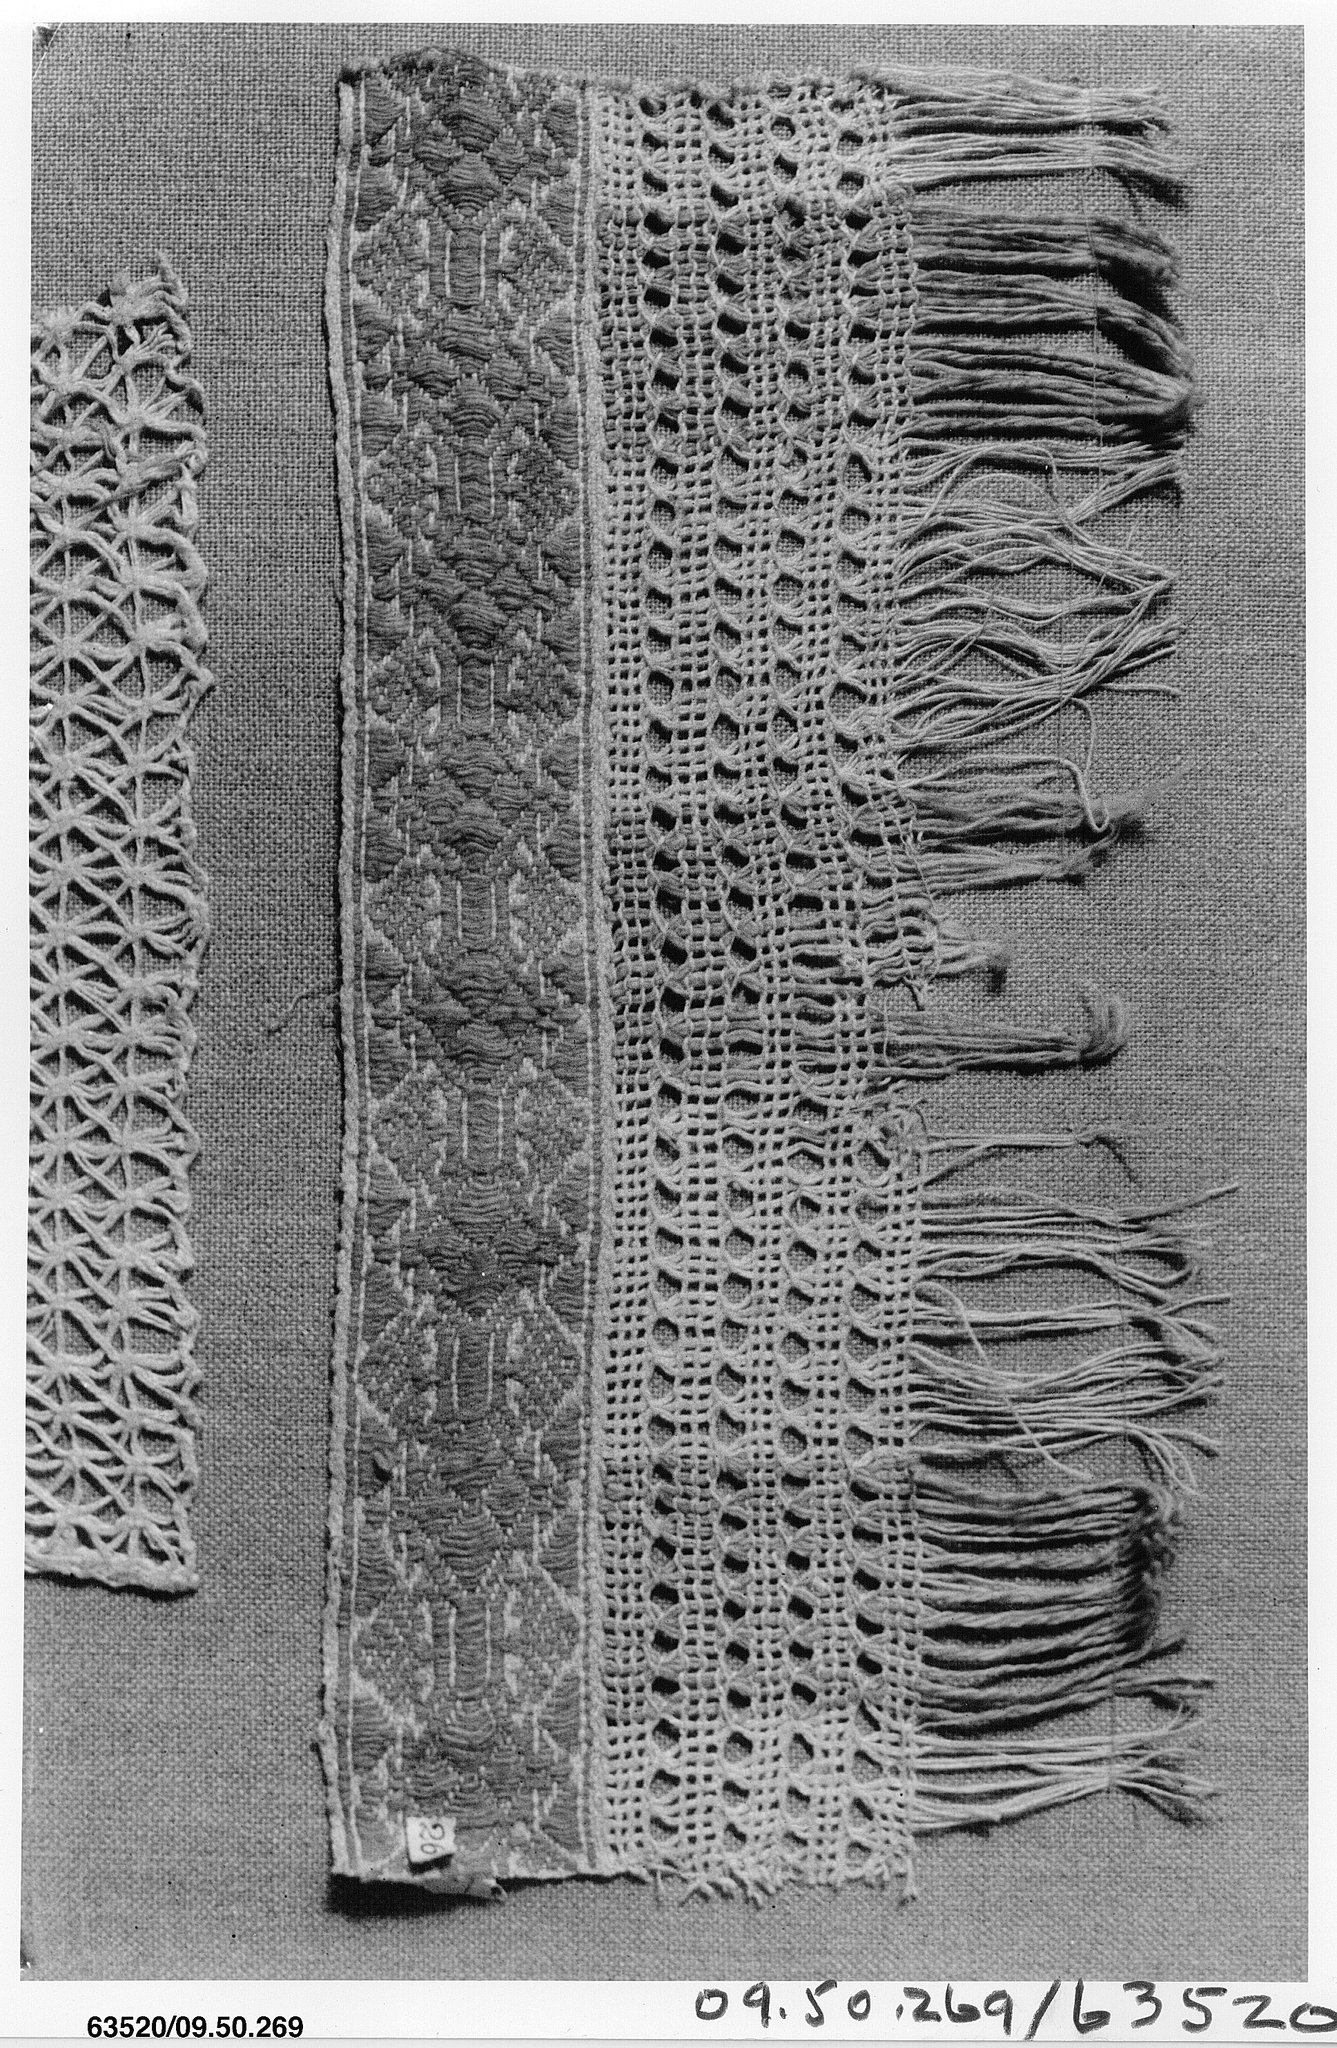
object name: fragment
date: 1701-1900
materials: cotton, linen